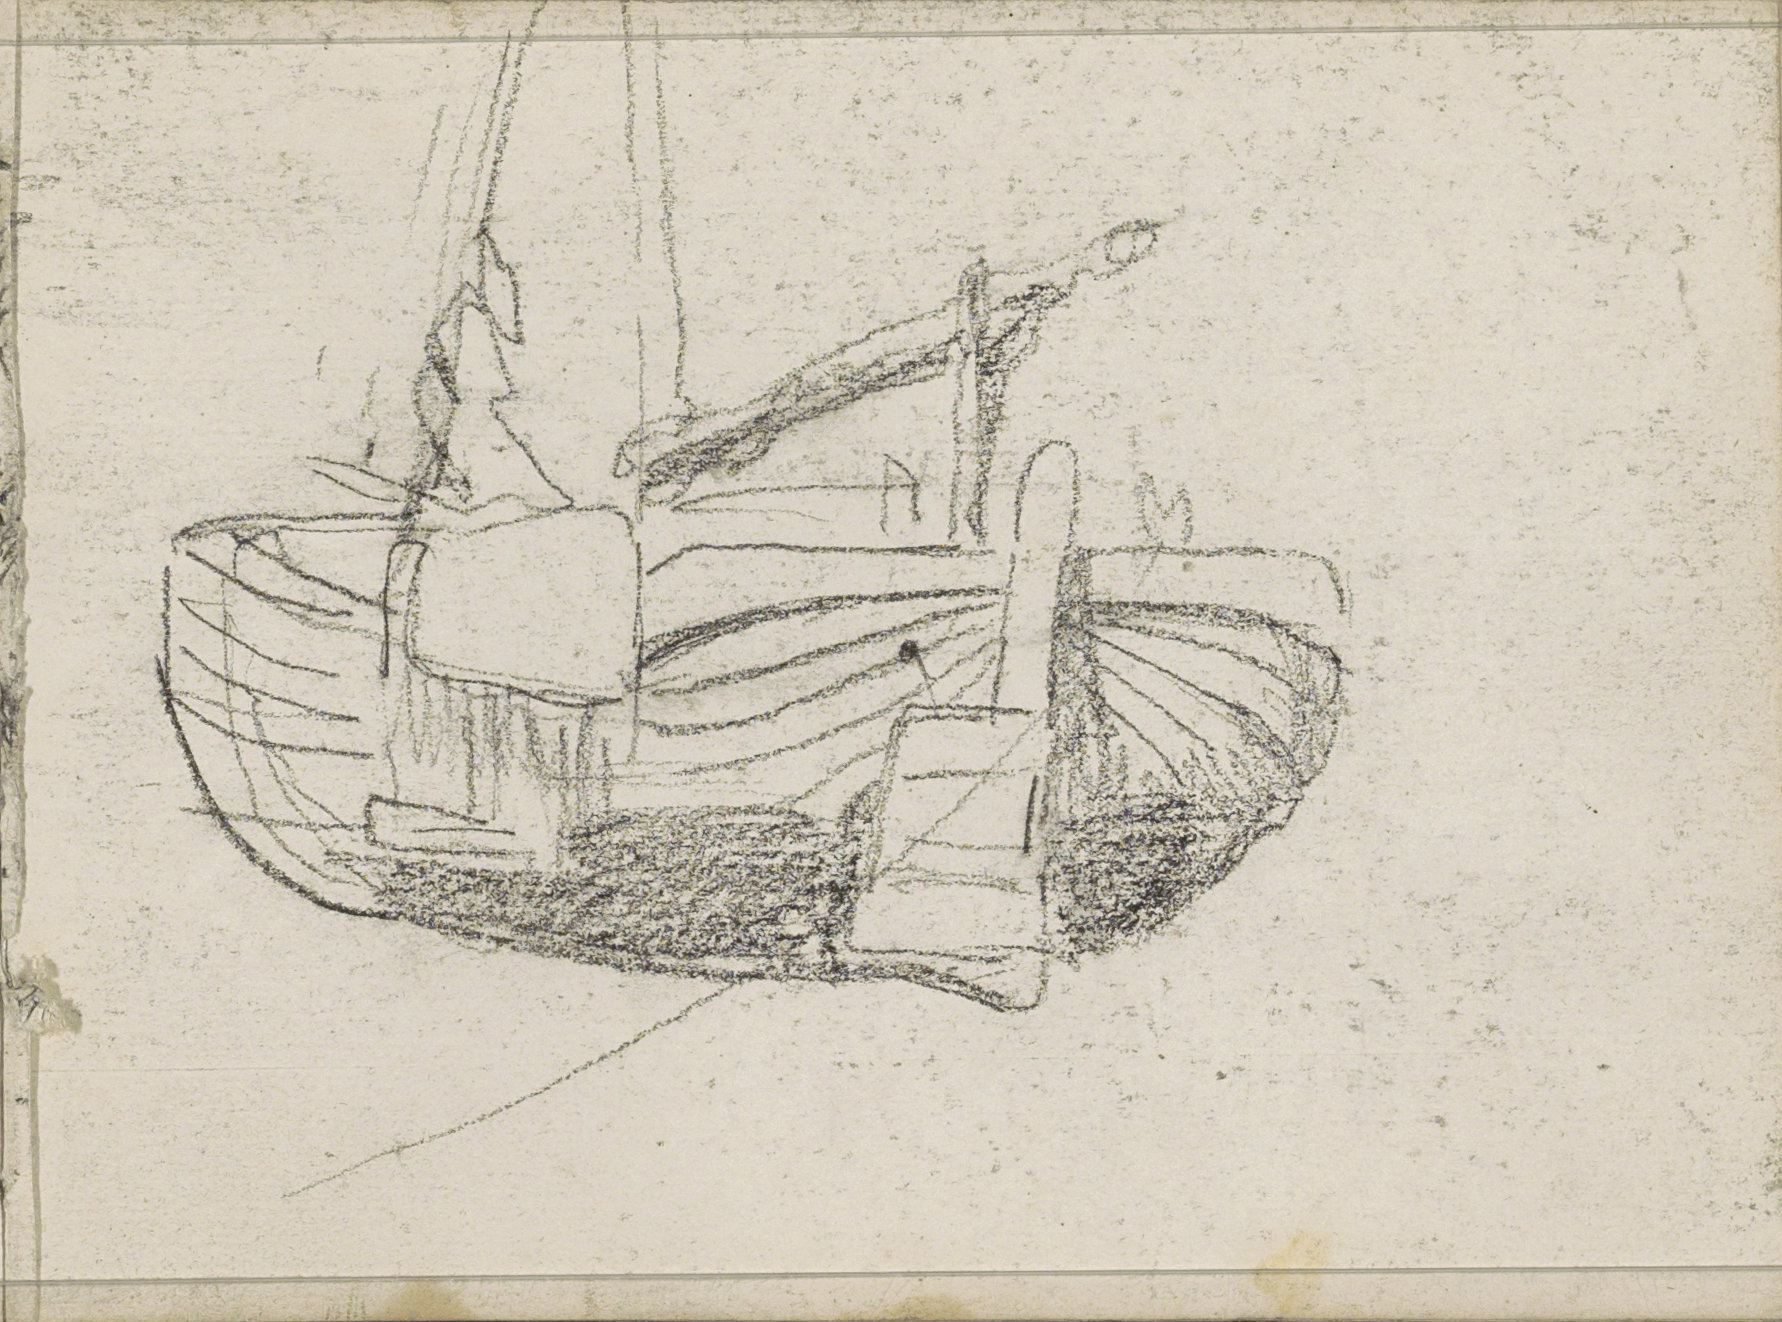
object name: sketchbook leaf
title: Bomschuit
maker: anton mauve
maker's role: draughtsman, painter, print maker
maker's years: 1838-1888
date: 1848-1888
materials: chalk, paper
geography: scheveningen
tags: sailing-ship, sailing-boat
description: Blad 14 recto uit een schetsboek met 33 bladen.